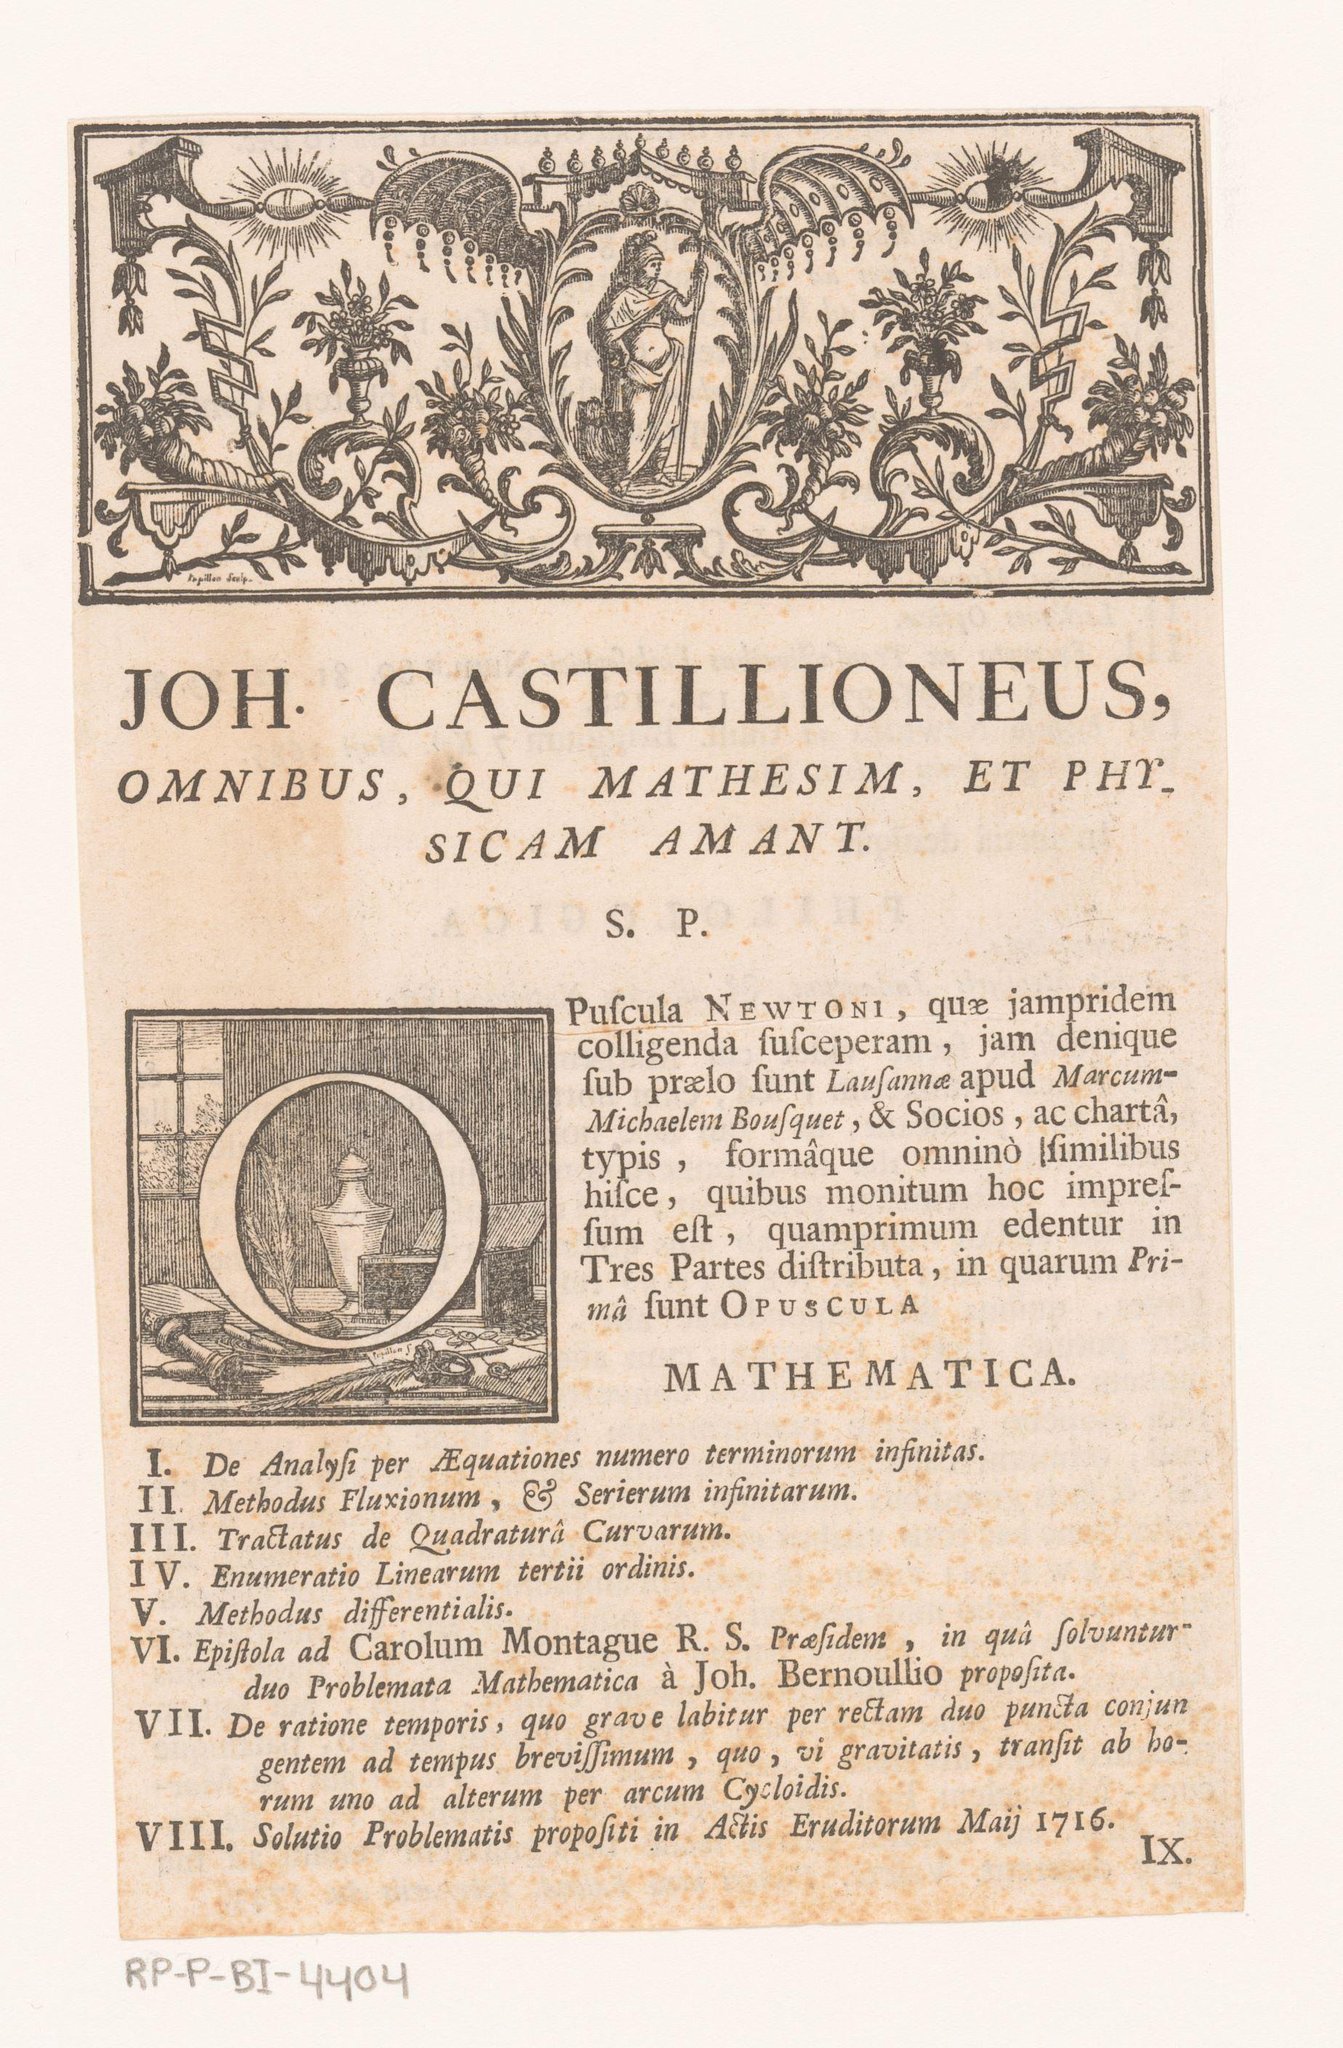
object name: print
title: Joh. Castillioneus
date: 1744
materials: paper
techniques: letterpress printing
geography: lausanne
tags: minerva as patroness, writing and letters, ornament derived from plant forms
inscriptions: collector's mark: Lugt 240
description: Prent uit: Newton, Isaac. Opuscula Mathematica, Philosophica et Philologica. Lausanne: Marc-Michel Bousquet, 1744.